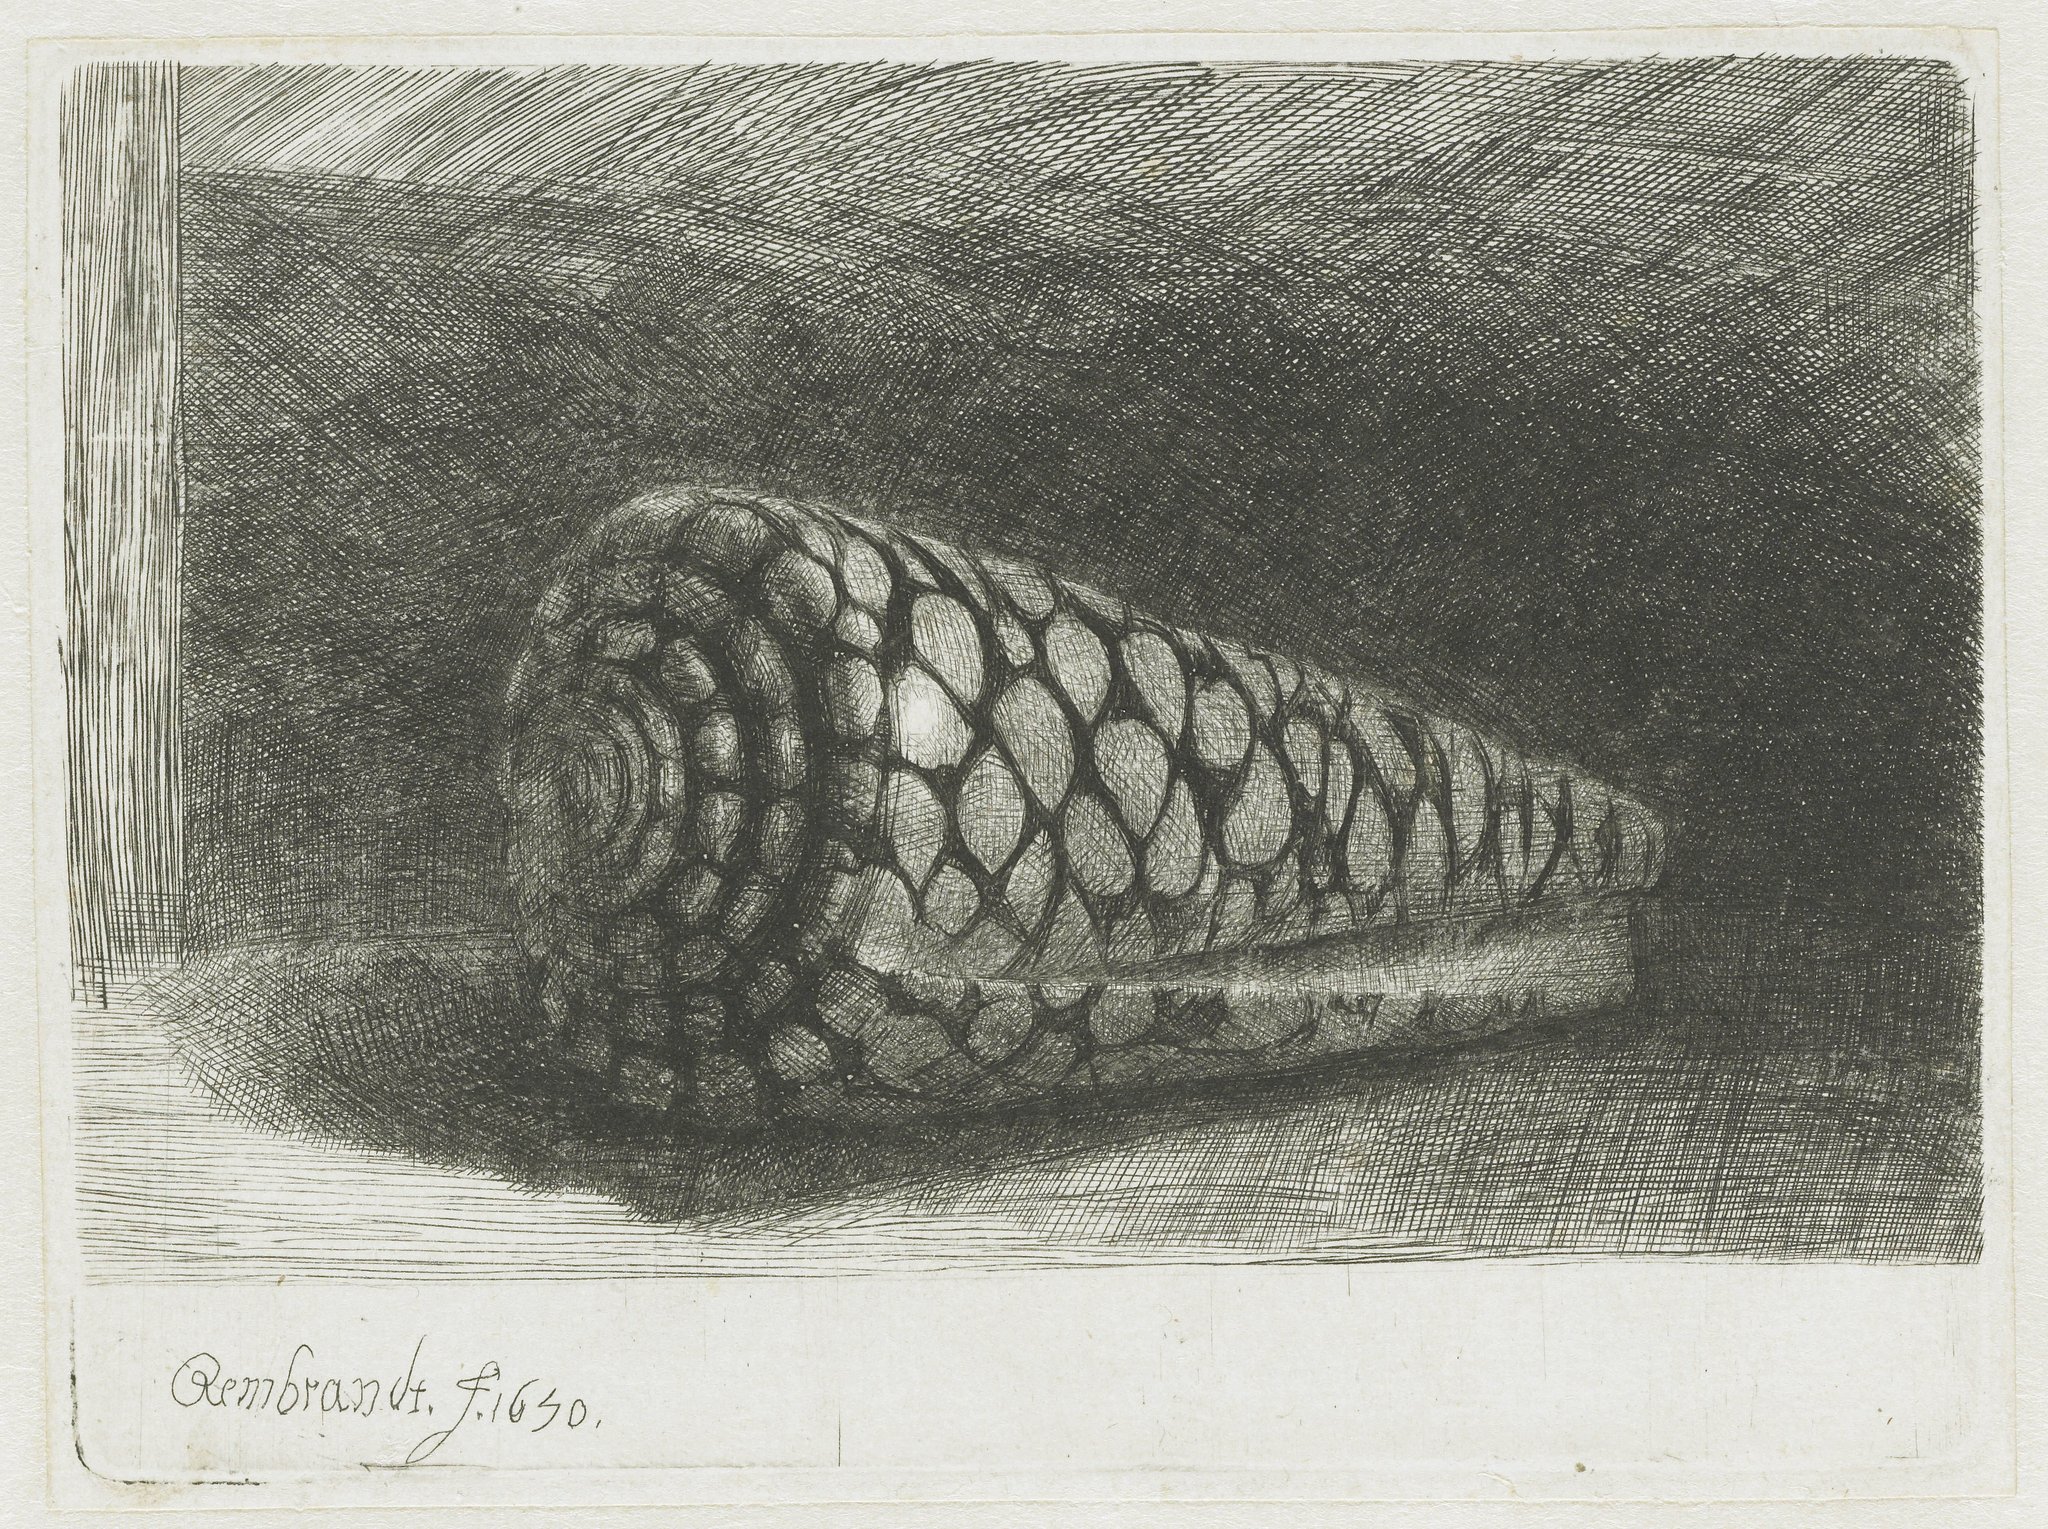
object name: print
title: The shell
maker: rembrandt van rijn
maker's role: draughtsman, painter, print maker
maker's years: 1606-1669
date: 1650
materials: paper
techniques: drypoint, etching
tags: molluscs (+ shell, snail-shell etc.)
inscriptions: signature and date: ‘Rembrandt f 1650’, mark: Lugt 2228, inscription: ‘C. 10627’, mark: Lugt 2773, mark: Lugt 176